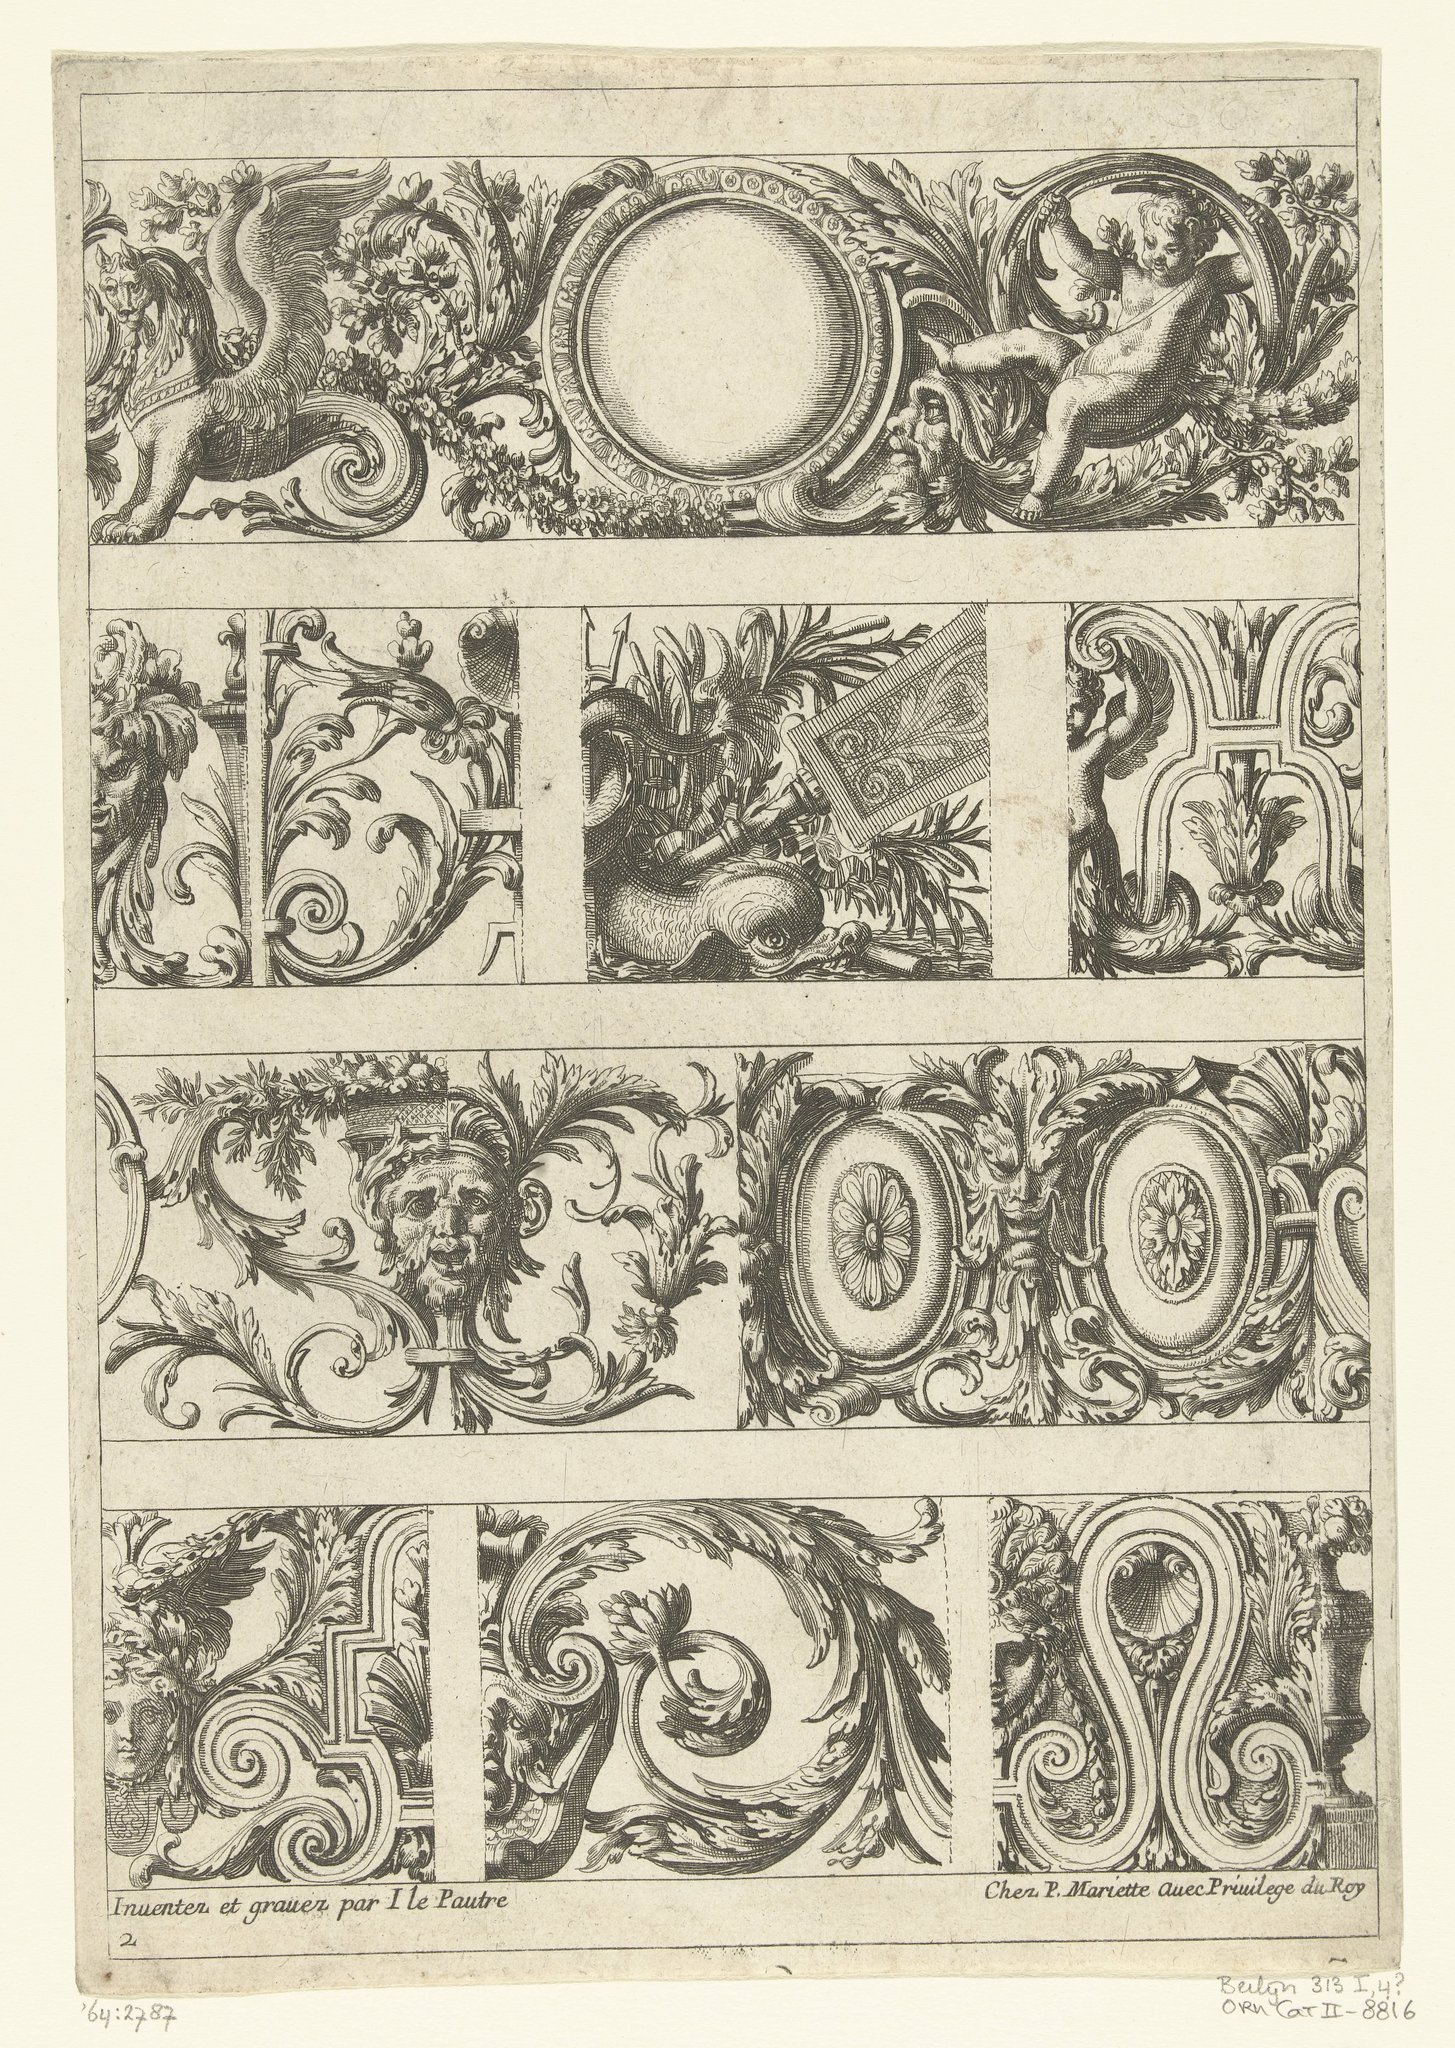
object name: print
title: Differents Morceaux d'Ornements Pour Seruir aux Frises Corniches et Architraues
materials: paper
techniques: etching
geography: paris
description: Het bovenste fries bestaat uit twee delen aan weerskanten van een rond medaillon, zonder weergave van de scheidingslijn. Blad 2 uit serie van 6 bladen, elk met vier rijen friezen, meestal verdeeld in twee tot vier compartimenten.